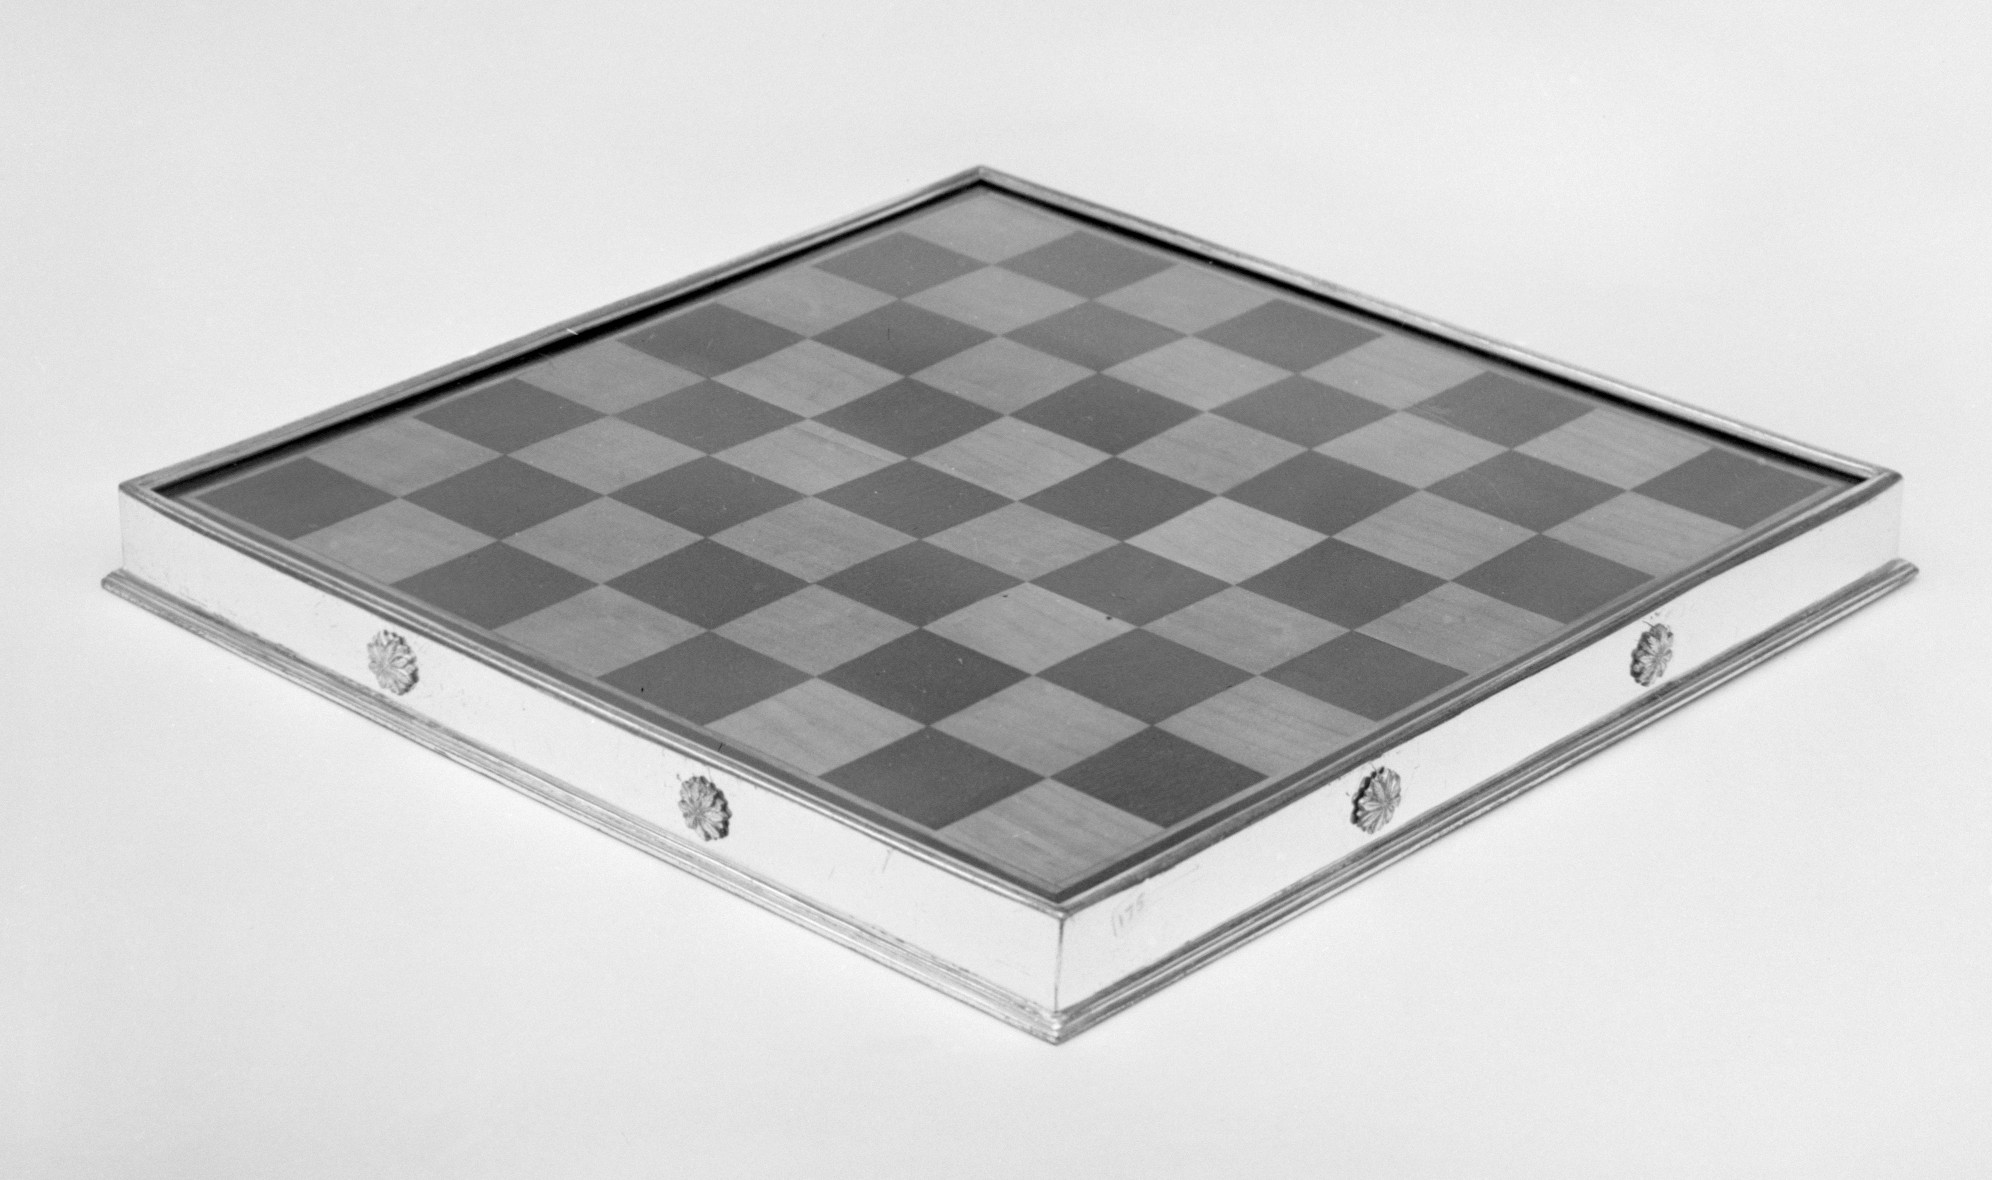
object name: chessboard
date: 1783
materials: silver, wood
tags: chess